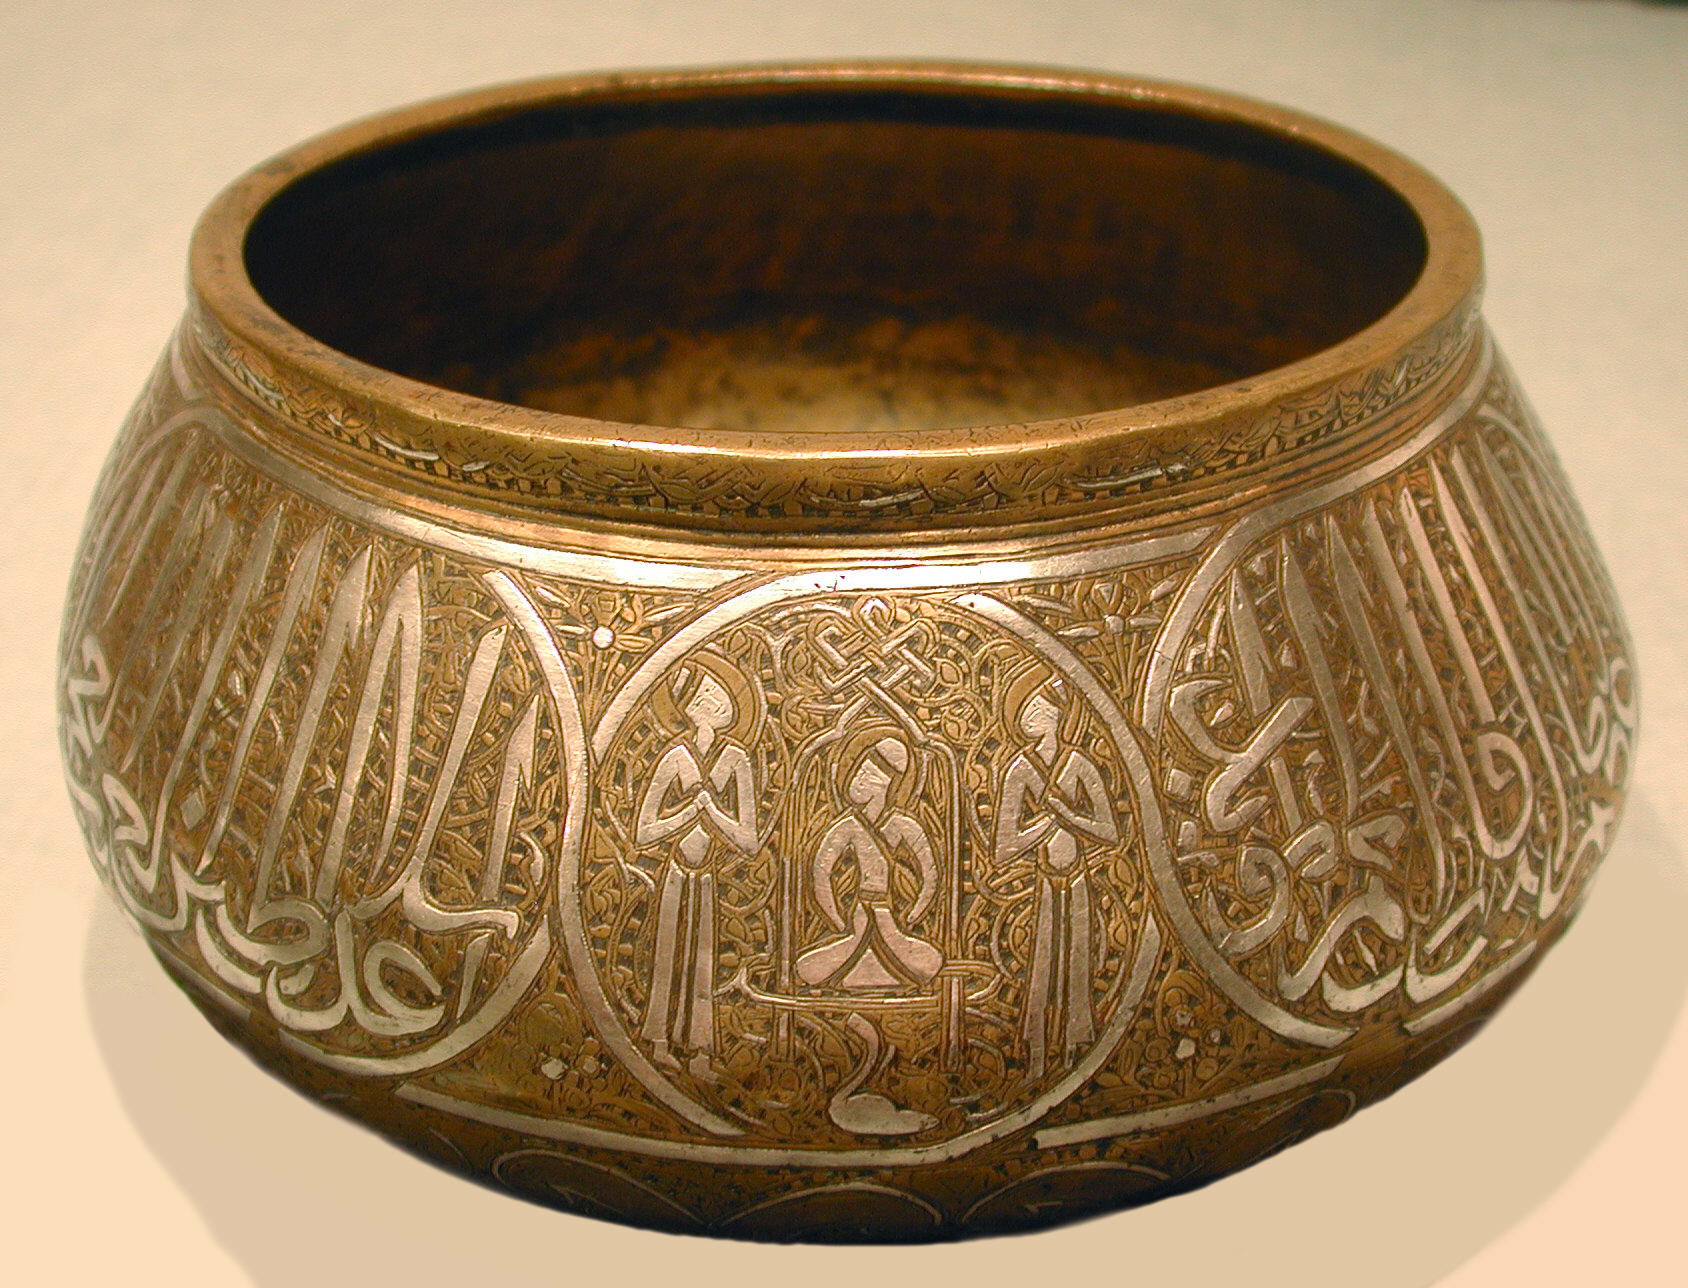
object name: bowl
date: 1351-1400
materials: brass, silver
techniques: engraving, inlay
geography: iran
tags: human figures